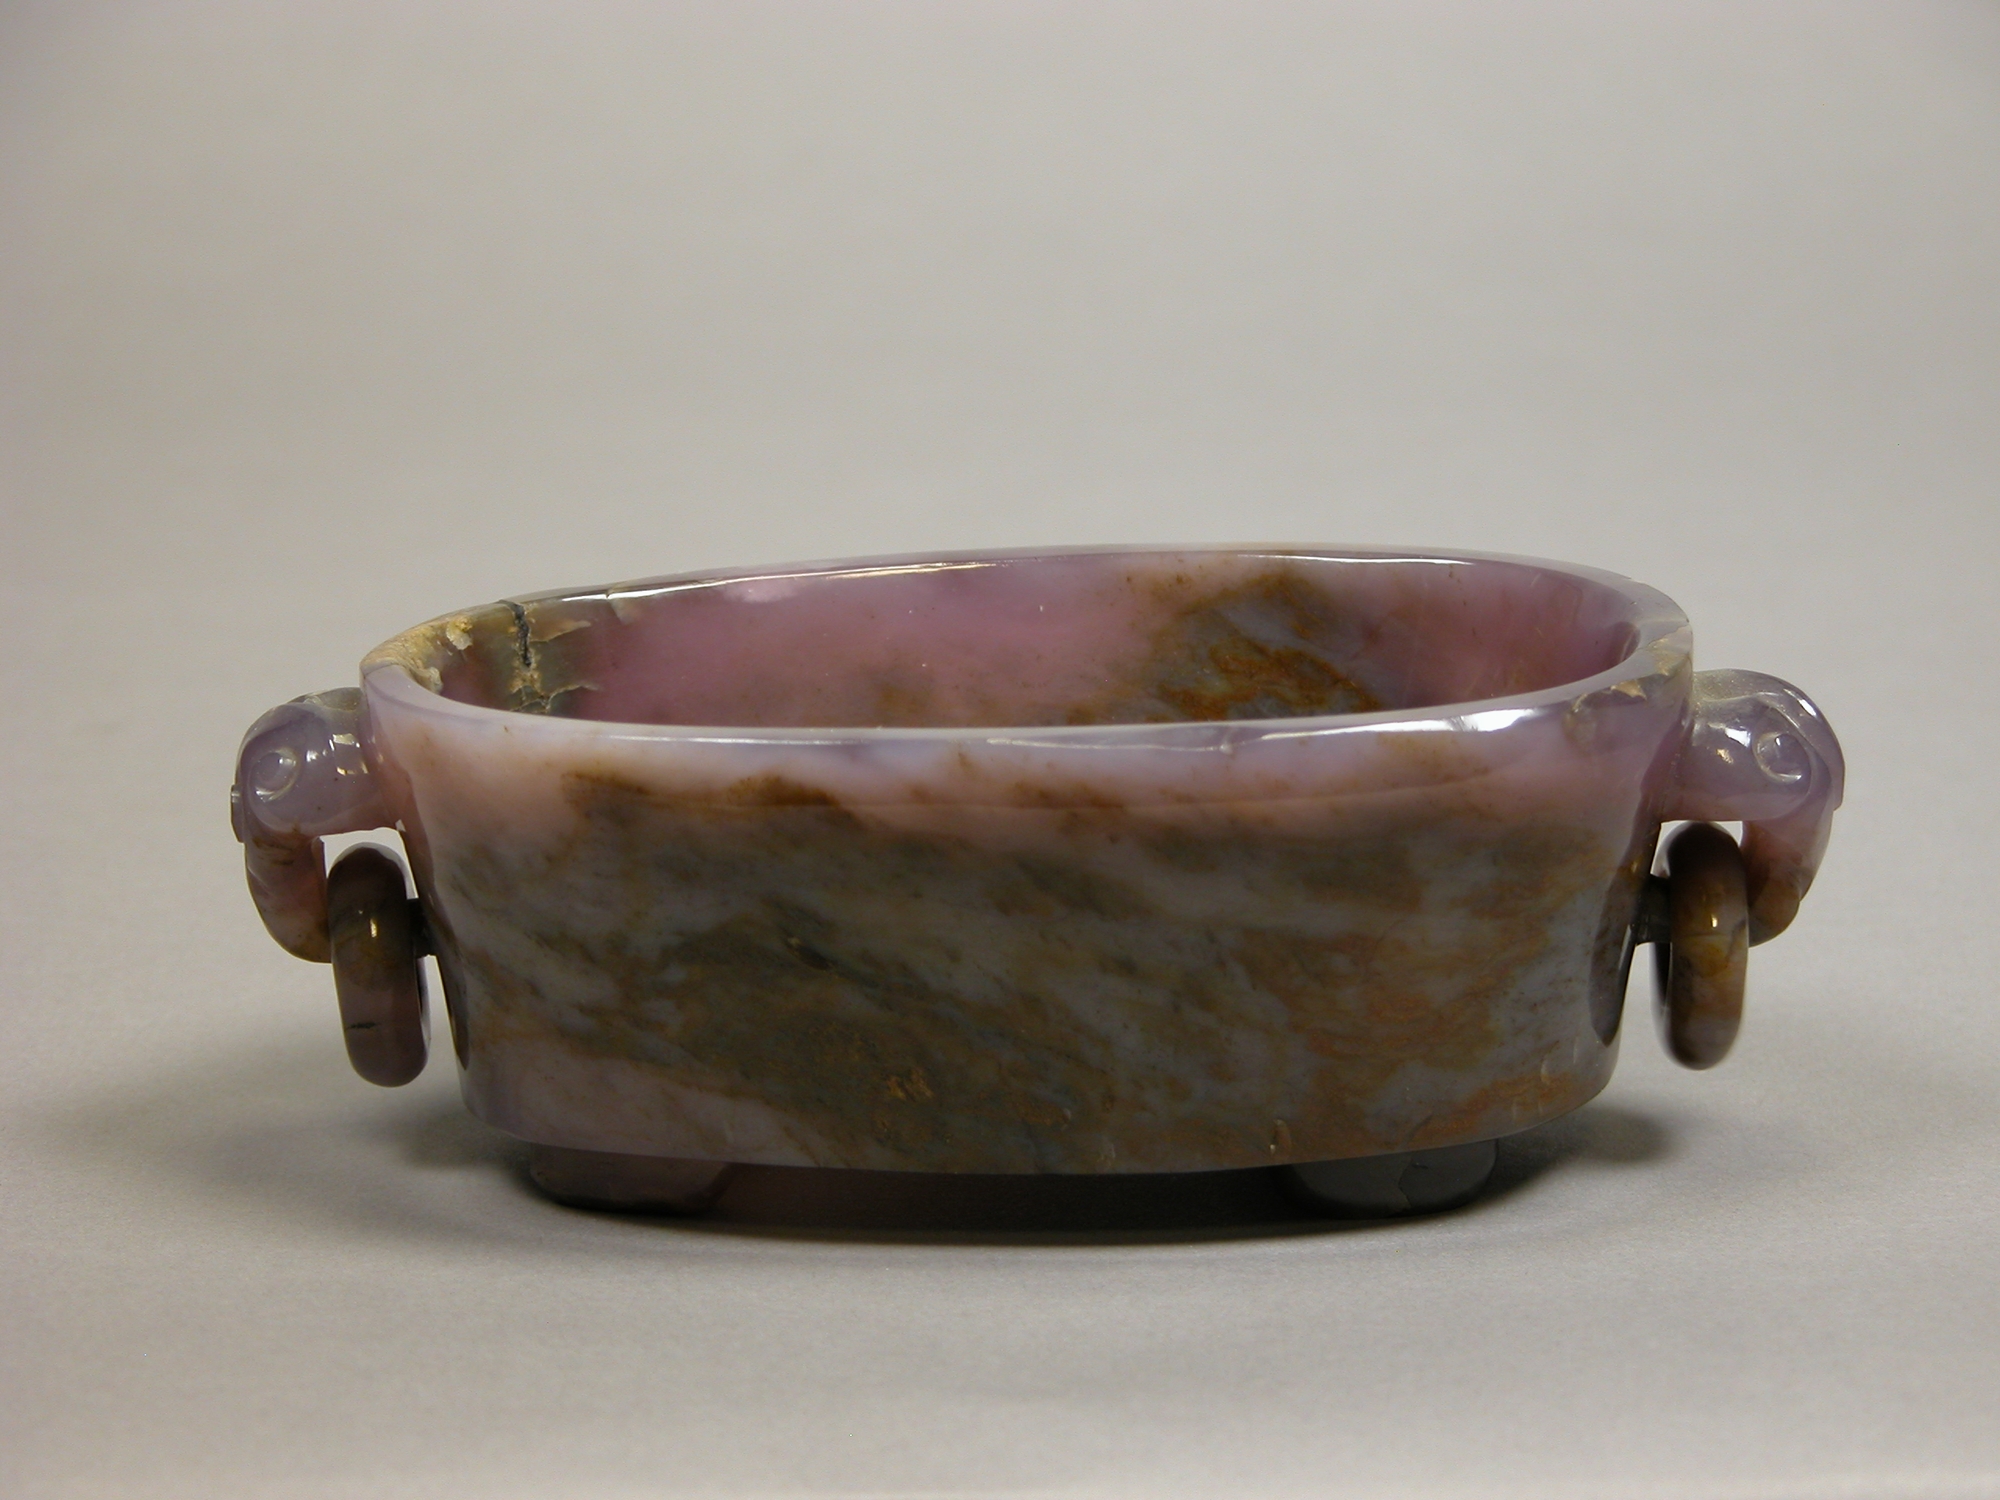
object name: vessel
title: Water vessel with loop handles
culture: chinese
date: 1644-1911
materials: stone